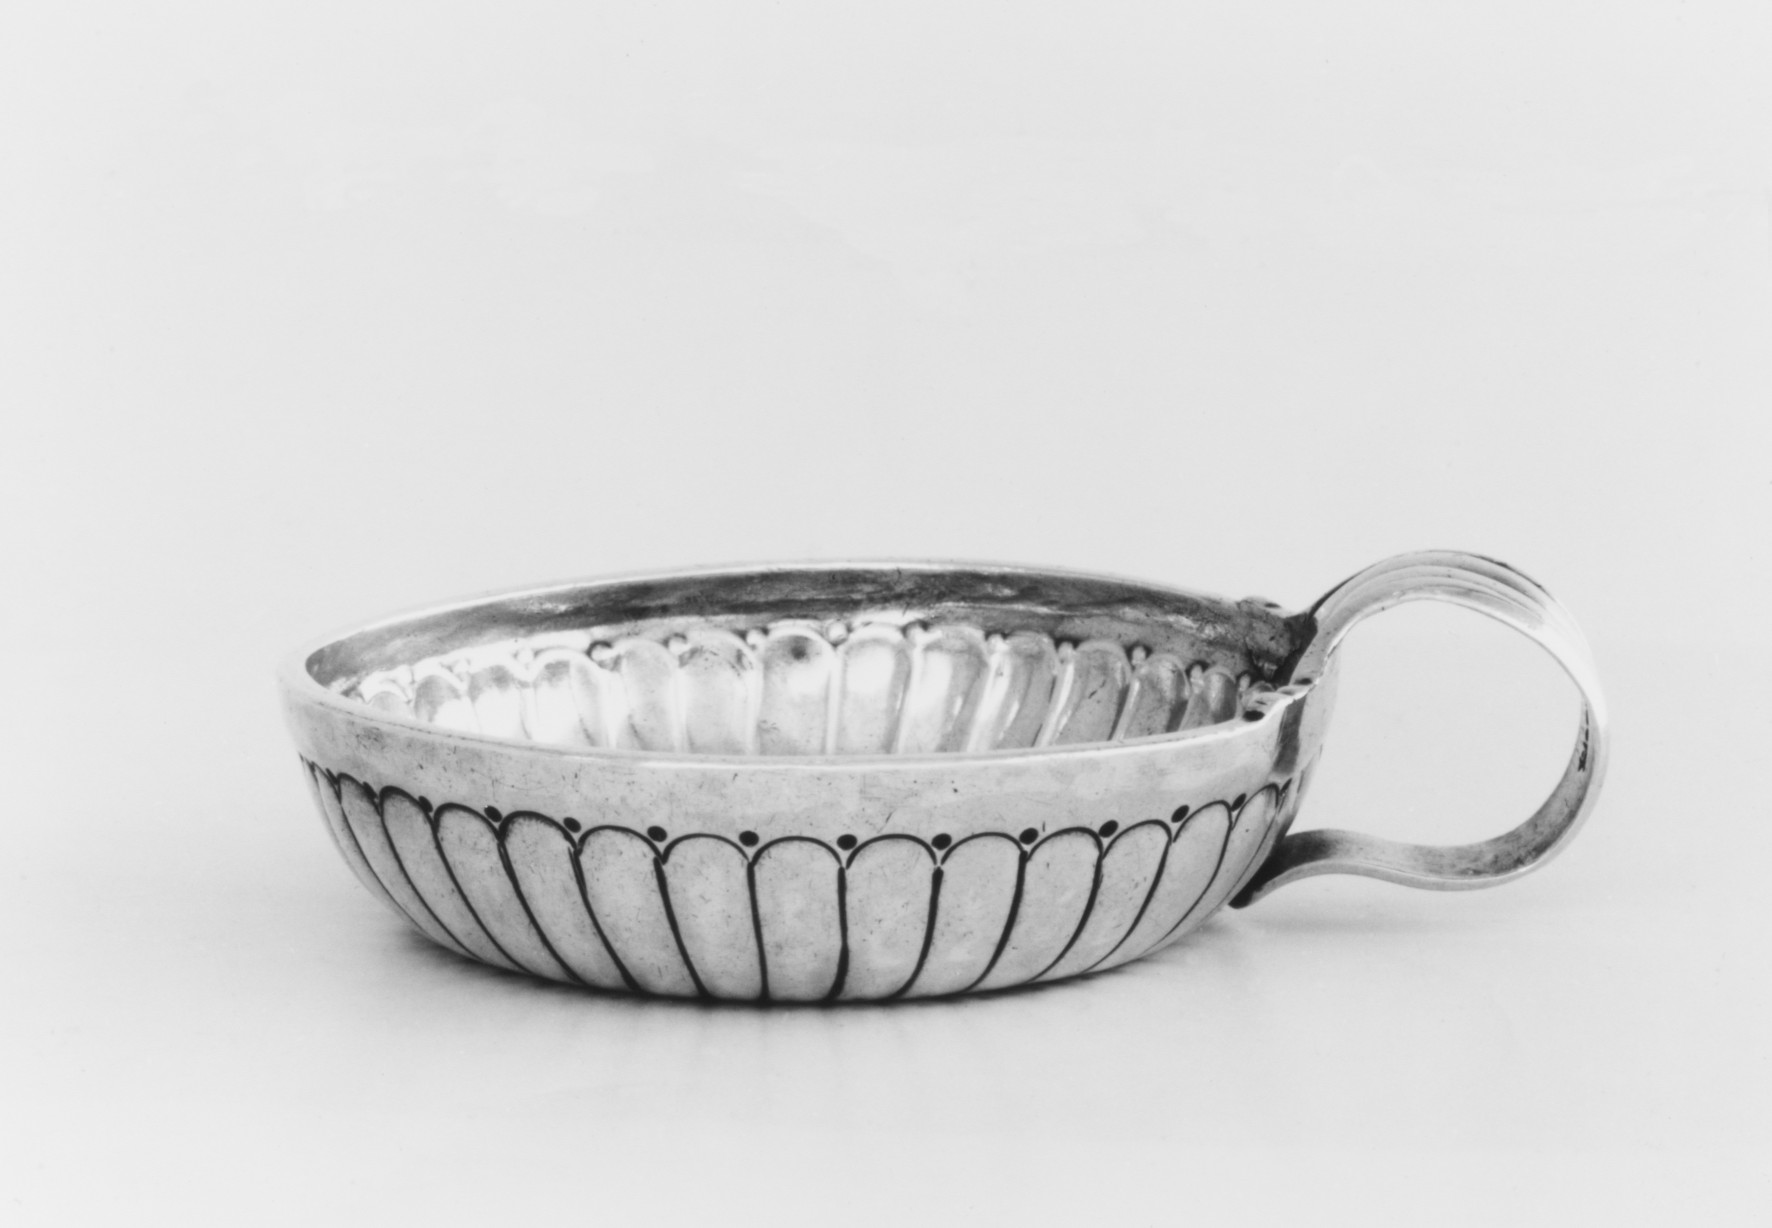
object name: wine taster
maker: jacques hanappier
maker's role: maker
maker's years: 1700-1760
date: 1758-1760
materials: silver